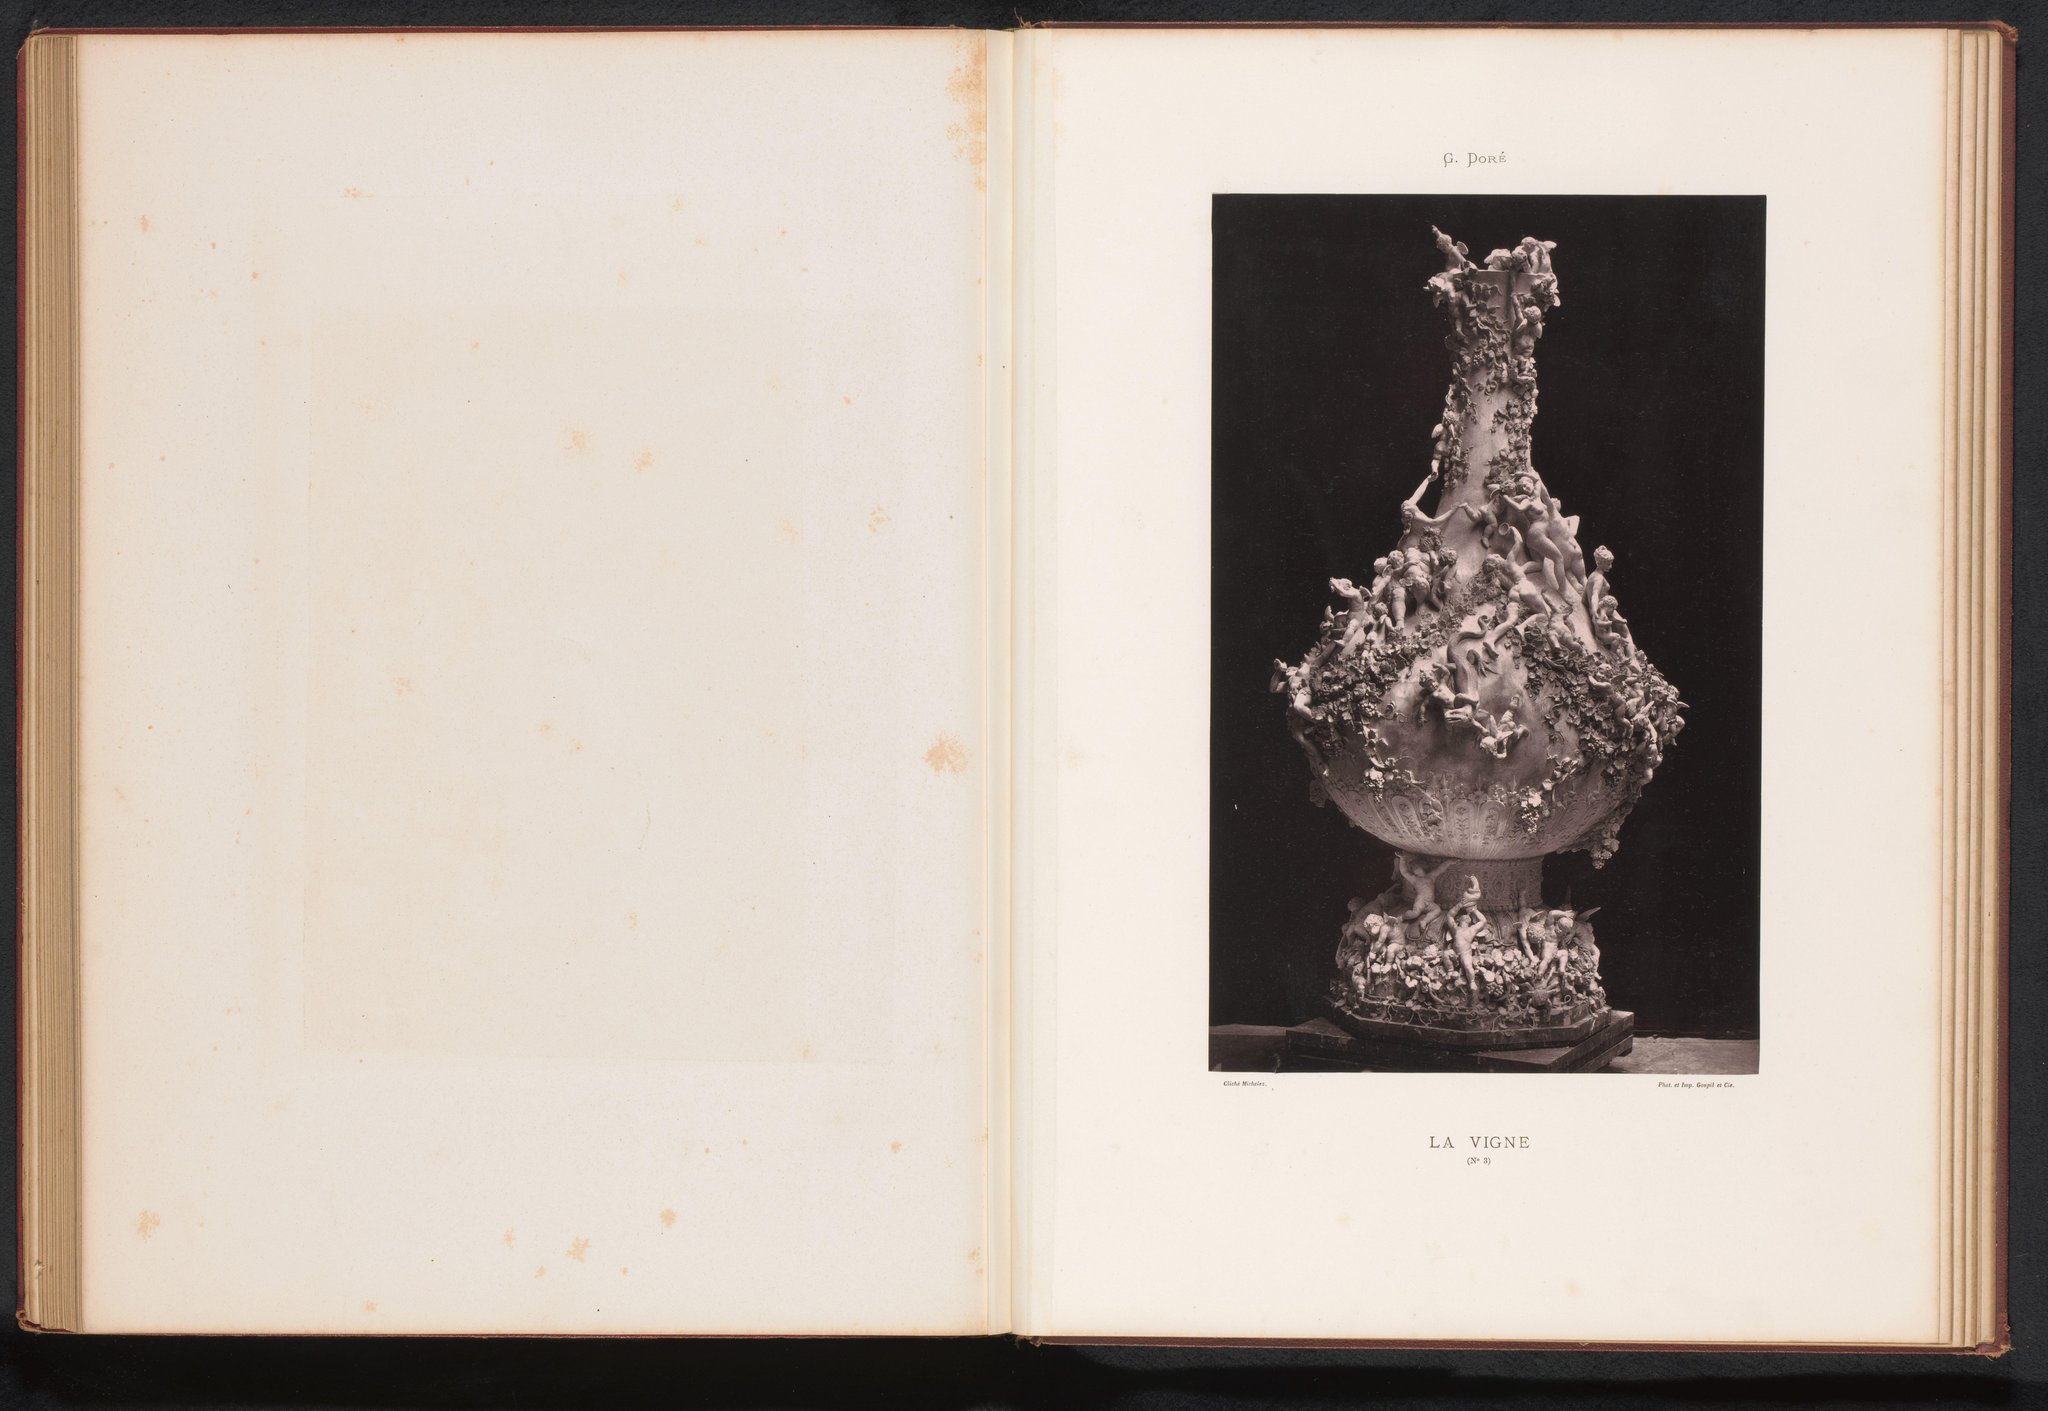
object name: reproduction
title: Reproductie van La Vigne door Gustave Doré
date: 1874-1879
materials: paper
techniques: woodburytype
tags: vine, sculpture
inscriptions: name: ‘G. Doré/ (No 3)’